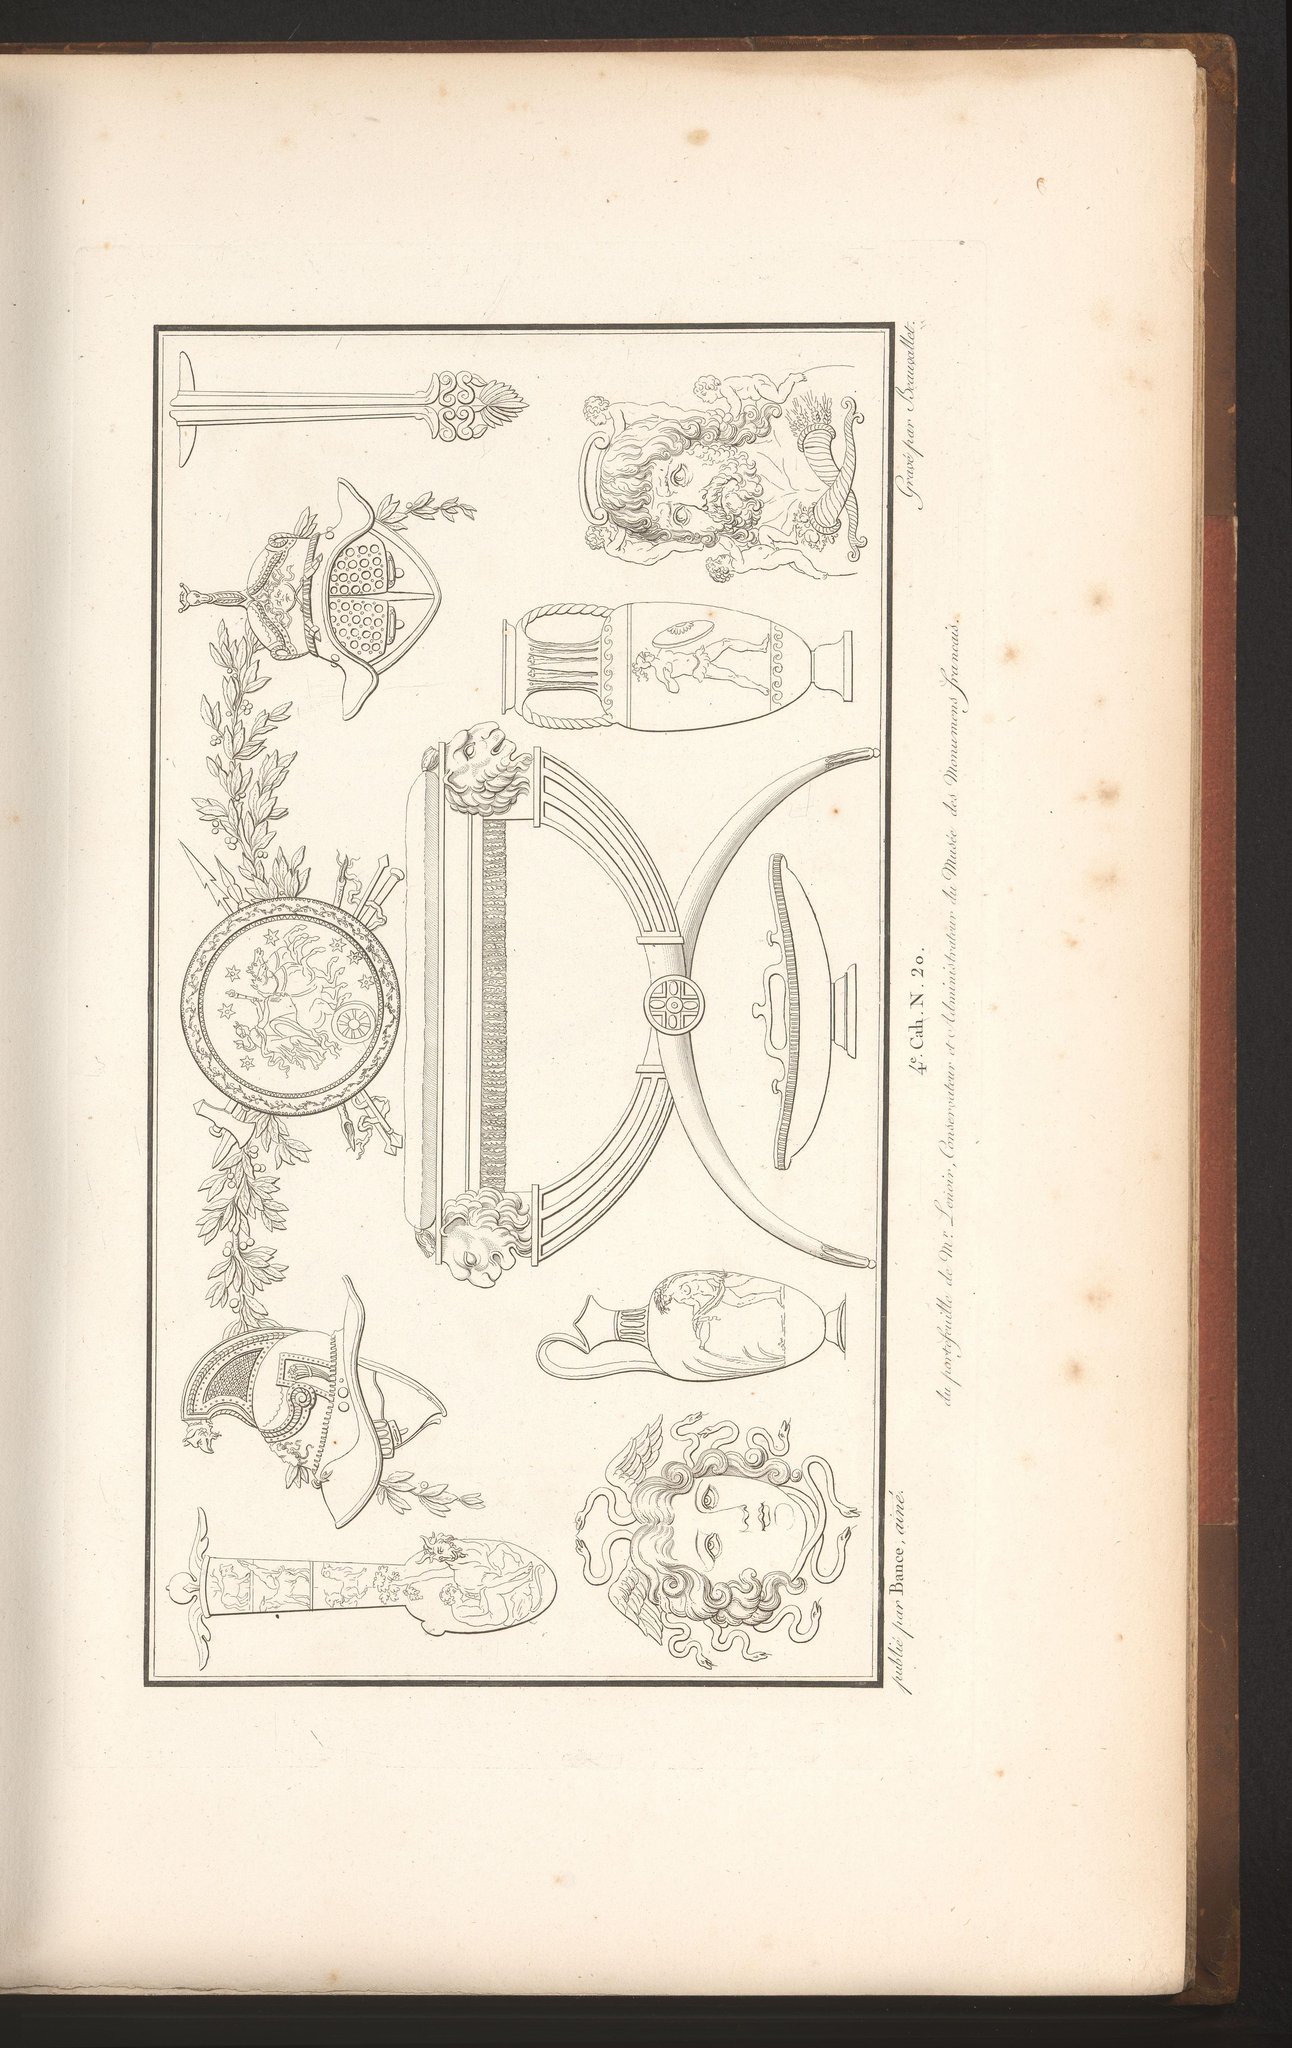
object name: ornament print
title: Diverse ornamenten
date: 1820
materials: paper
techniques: etching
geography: paris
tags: decorative furniture, ornaments ~ art, chair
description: Ornamentprent met diverse ornamenten in Grieks-Romeinse stijl, centraal een stoel. Onderdeel (4e. Cah. N. 20) van het prentalbum met twee series van in totaal 138 ornamentprenten door Beauvallet en Normand, 'Fragmens d'Ornemens dans le Style Antique'.